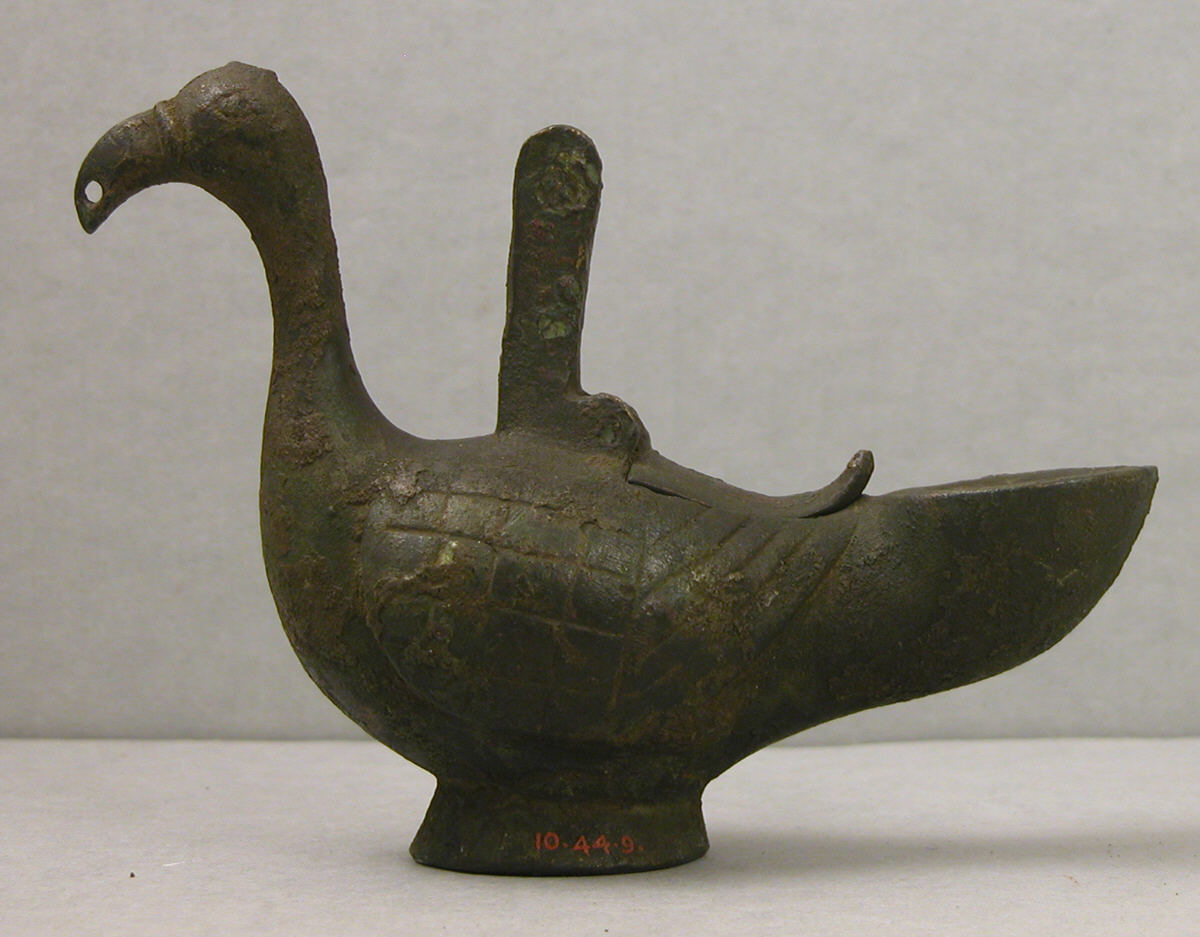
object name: lamp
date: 601-800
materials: bronze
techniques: casting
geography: egypt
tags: birds